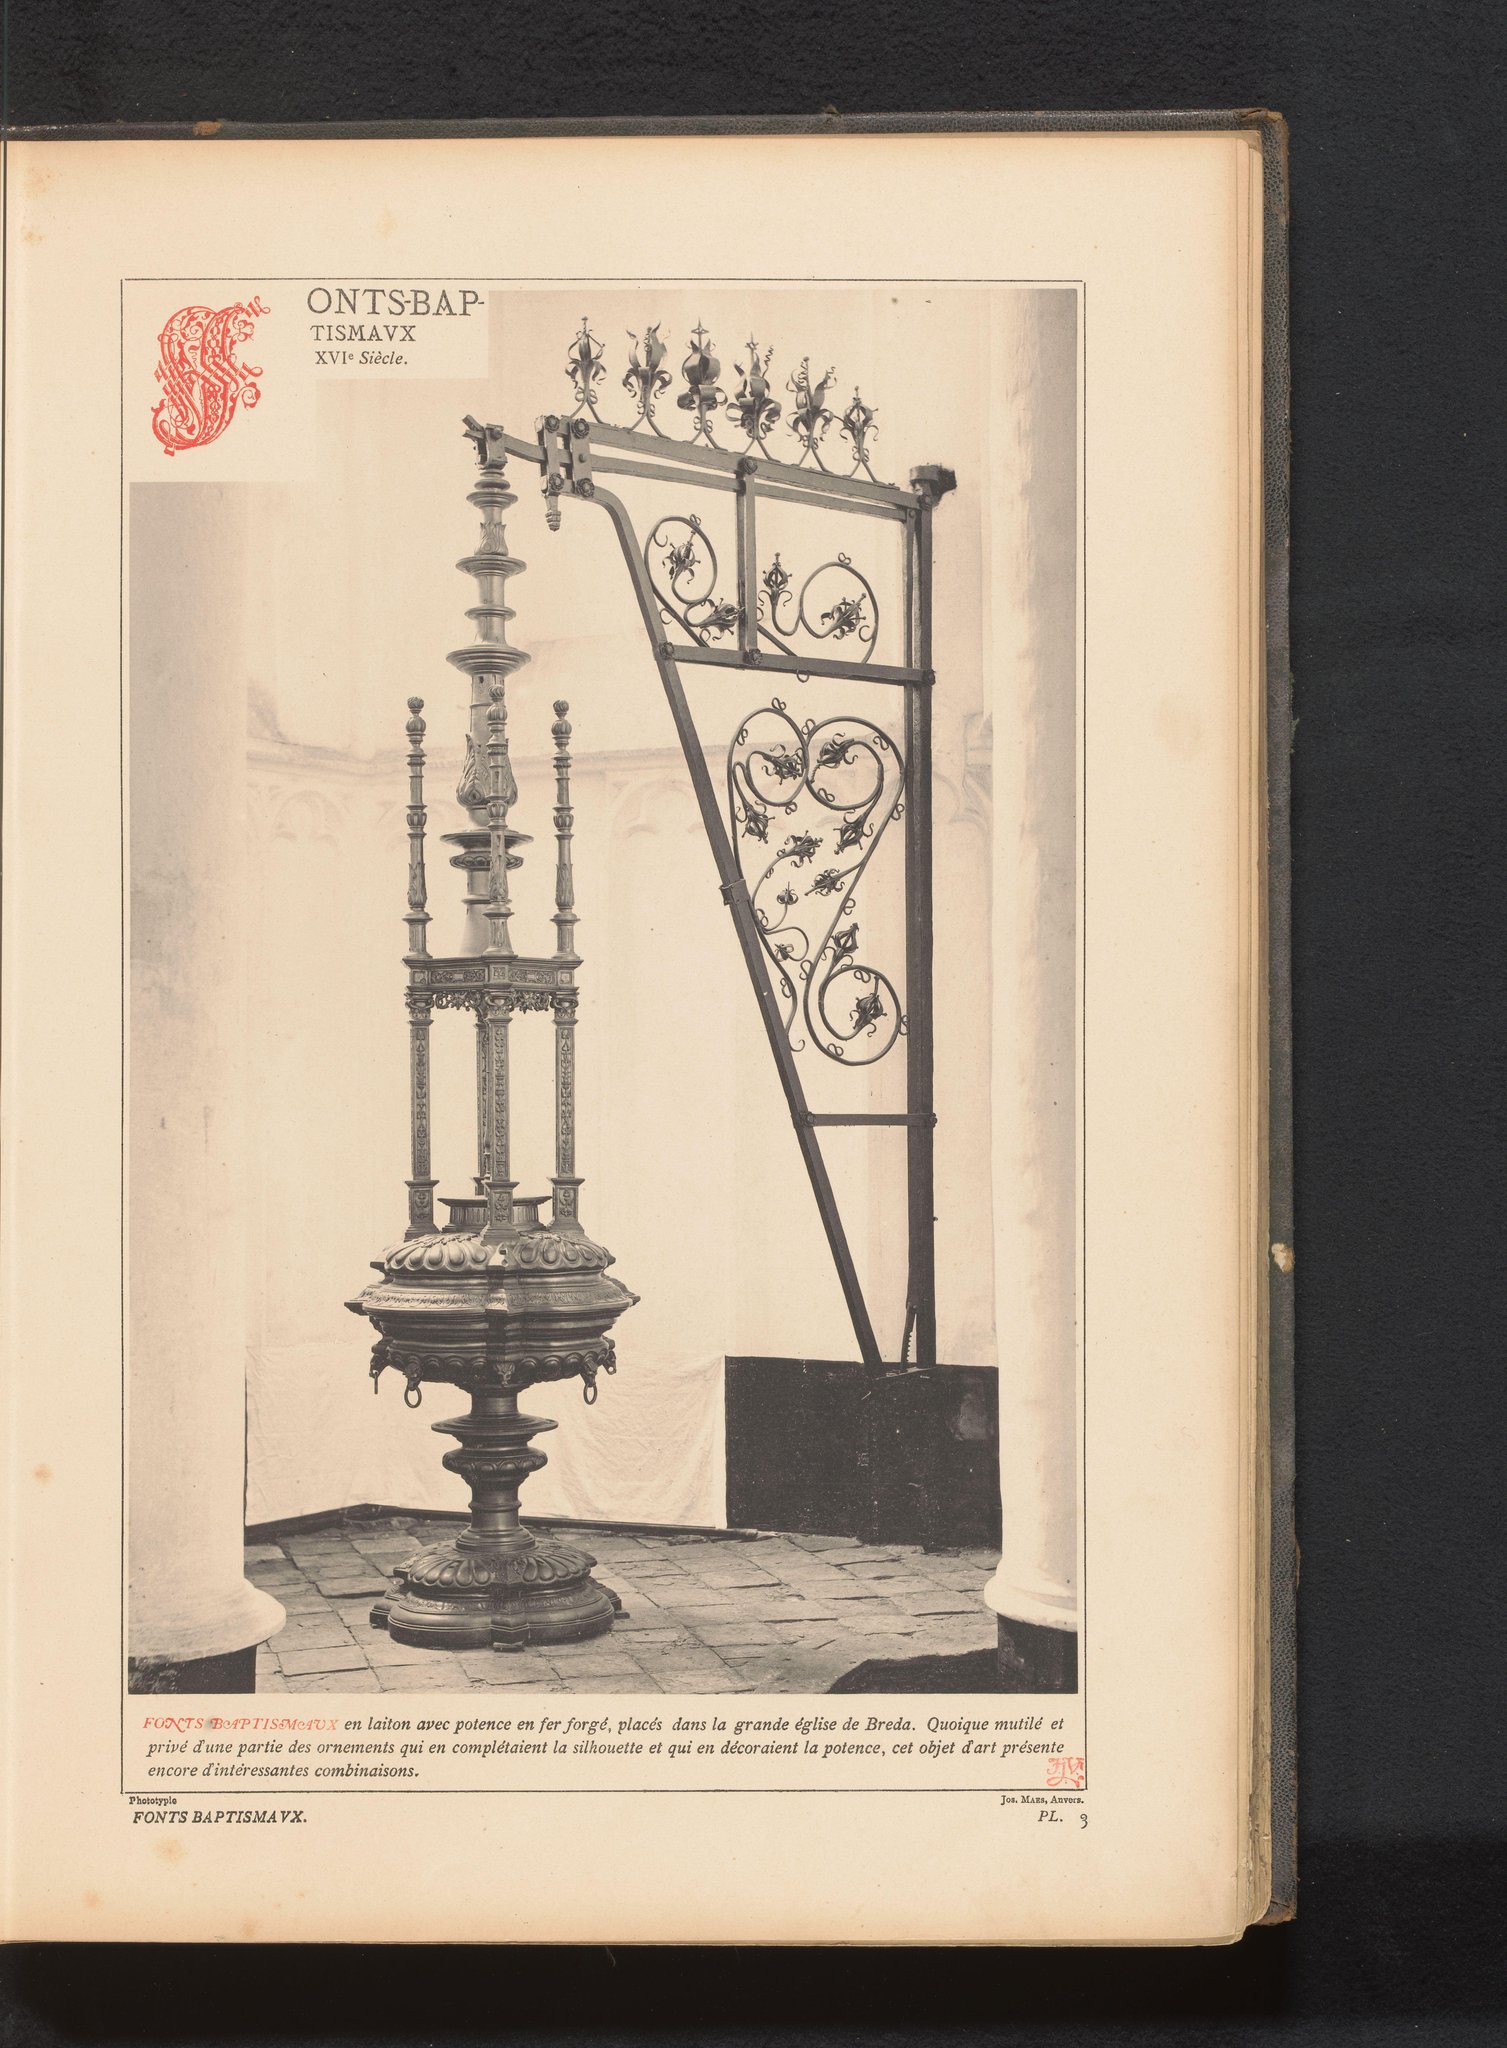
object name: photomechanical print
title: Doopvont in de Grote Kerk te Breda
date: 1881-1889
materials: paper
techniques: photograph, photolithography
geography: antwerp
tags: interior of church, baptismal font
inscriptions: monogram: ‘JJvY’, inscription: ‘FONTS BAPTISMAUX en laiton (...)’, inscription: ‘FONTS BAPTISMAUX. PL. 3.’